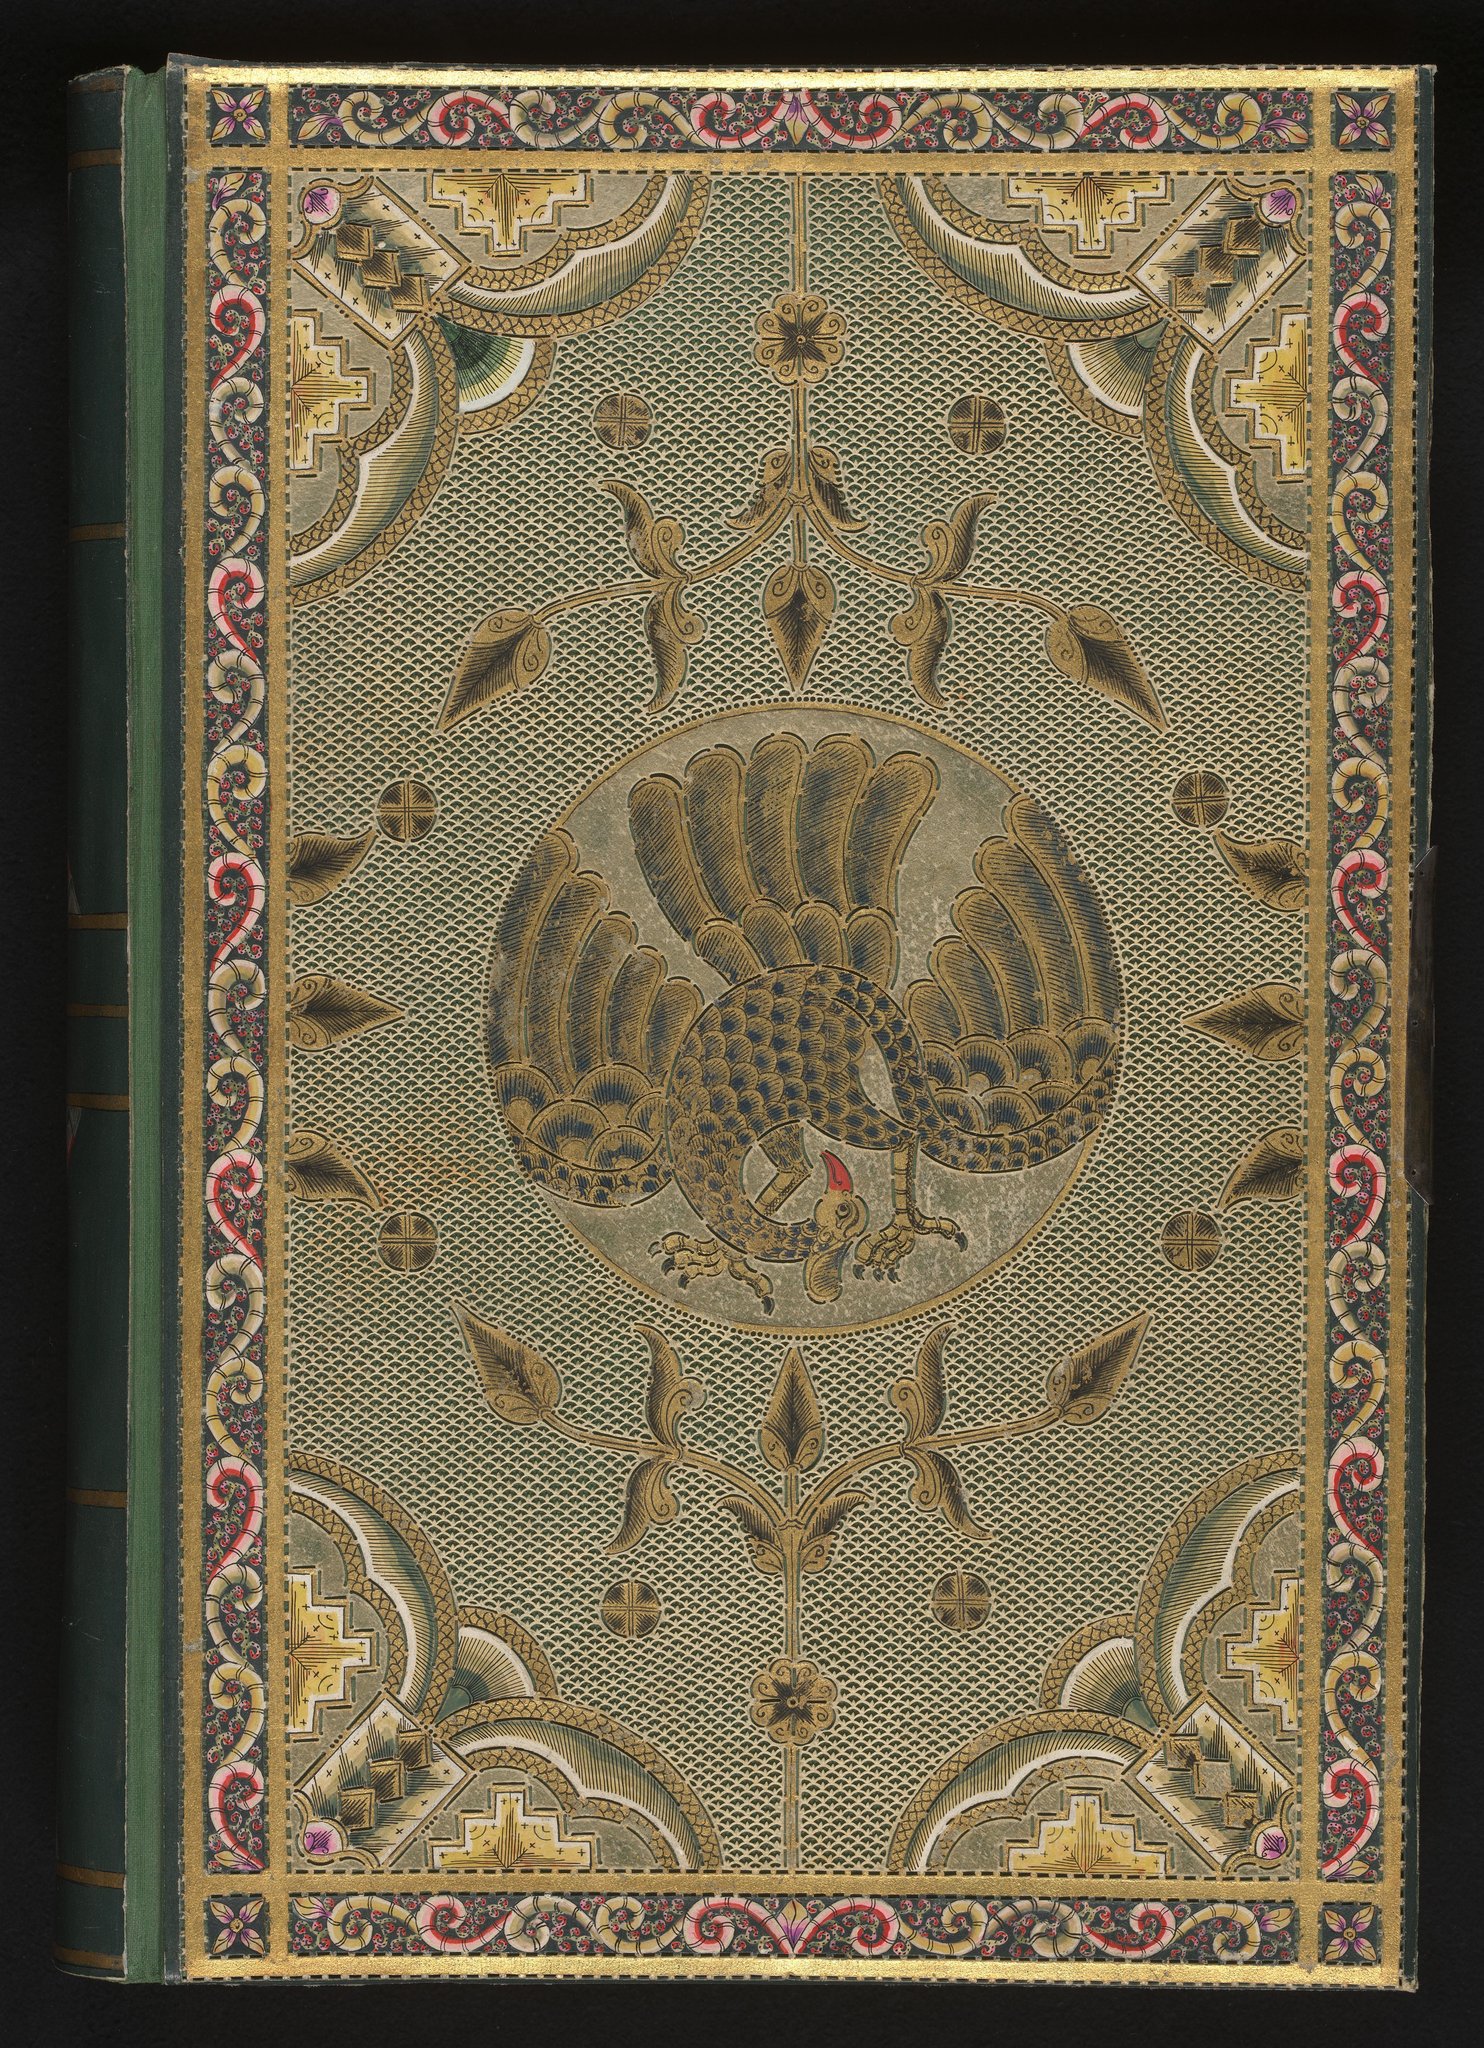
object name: photograph album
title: Souvenir Presented by the Staff of the Banka Tin Mining Enterprise to their Supervisor Mr R.J. Boers upon his Departure for the Netherlands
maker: Anonymous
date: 1919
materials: cardboard, linen, photographic support, silver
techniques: drawing, gelatin silver print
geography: bangka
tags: robert julius boers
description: The pages in this album feature a cross-section of the middle management at the Netherlands tin mining enterprise on the Indonesian island of Banka. Chinese, Javanese, and Indo-Europeans worked side by side. The lower level personnel were also recruited from elsewhere as contract labourers. They worked in deplorable conditions.